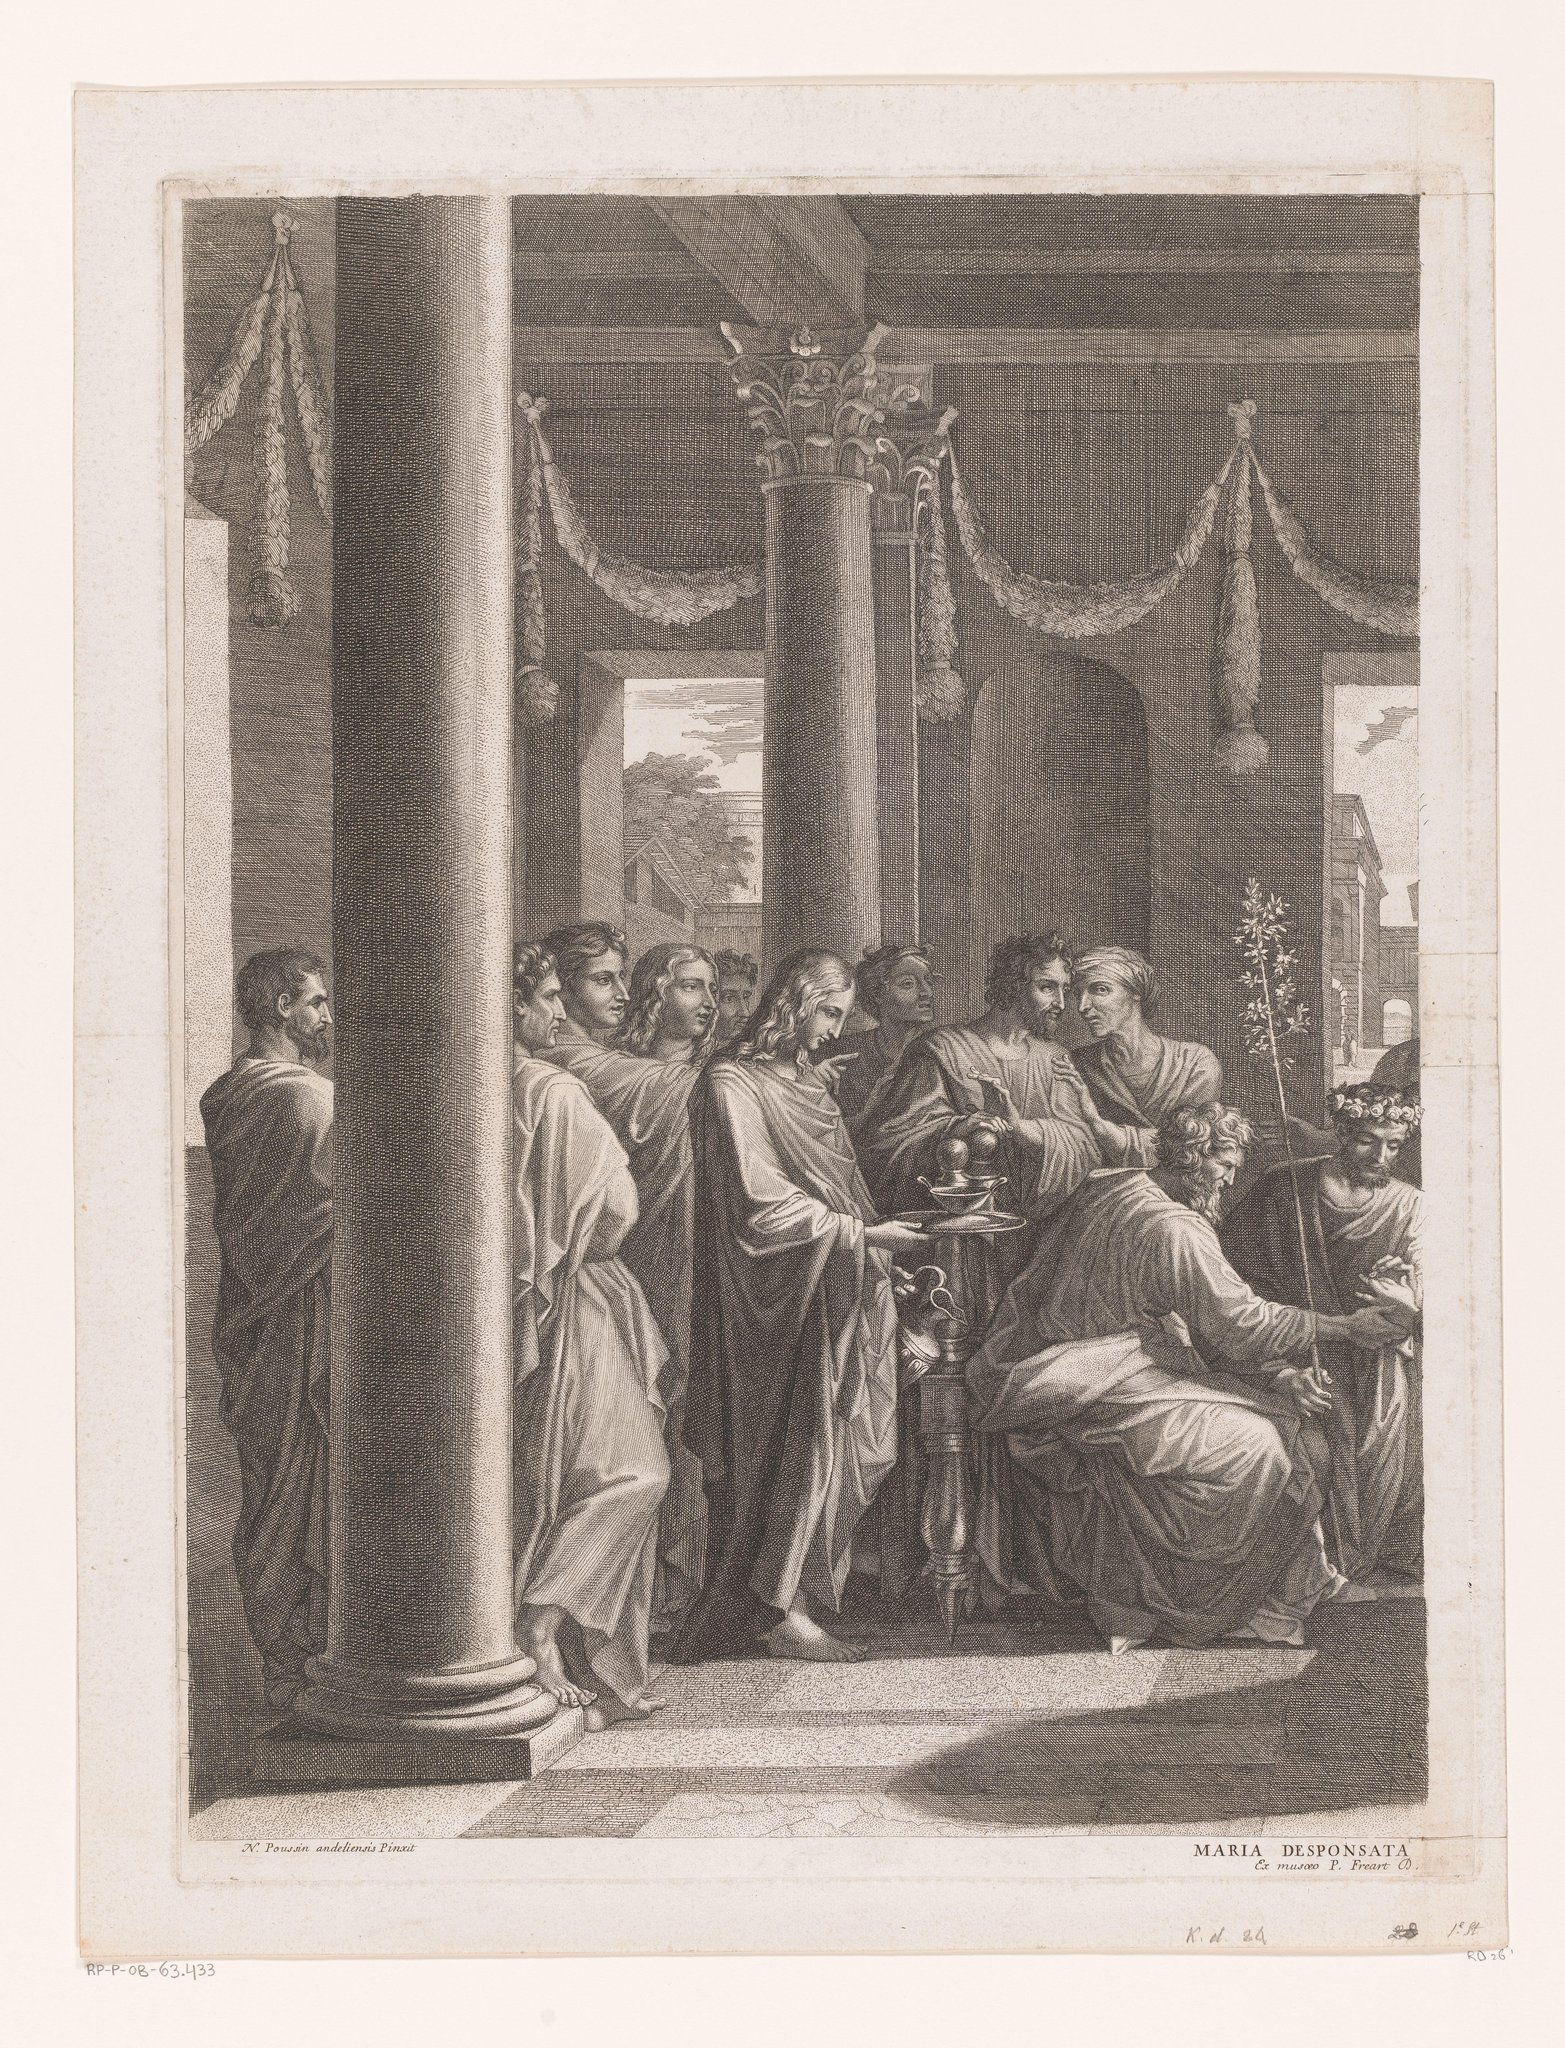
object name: print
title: Zeven sacramenten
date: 1633-1700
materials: paper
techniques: etching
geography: france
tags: marriage in church ~ the sixth of the seven sacraments, marriage of mary and joseph, 'sposalizio': they are married by the high priest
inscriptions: collector's mark: Lugt 240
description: Prent maakt deel uit van een ongenummerde serie van zeven prenten.